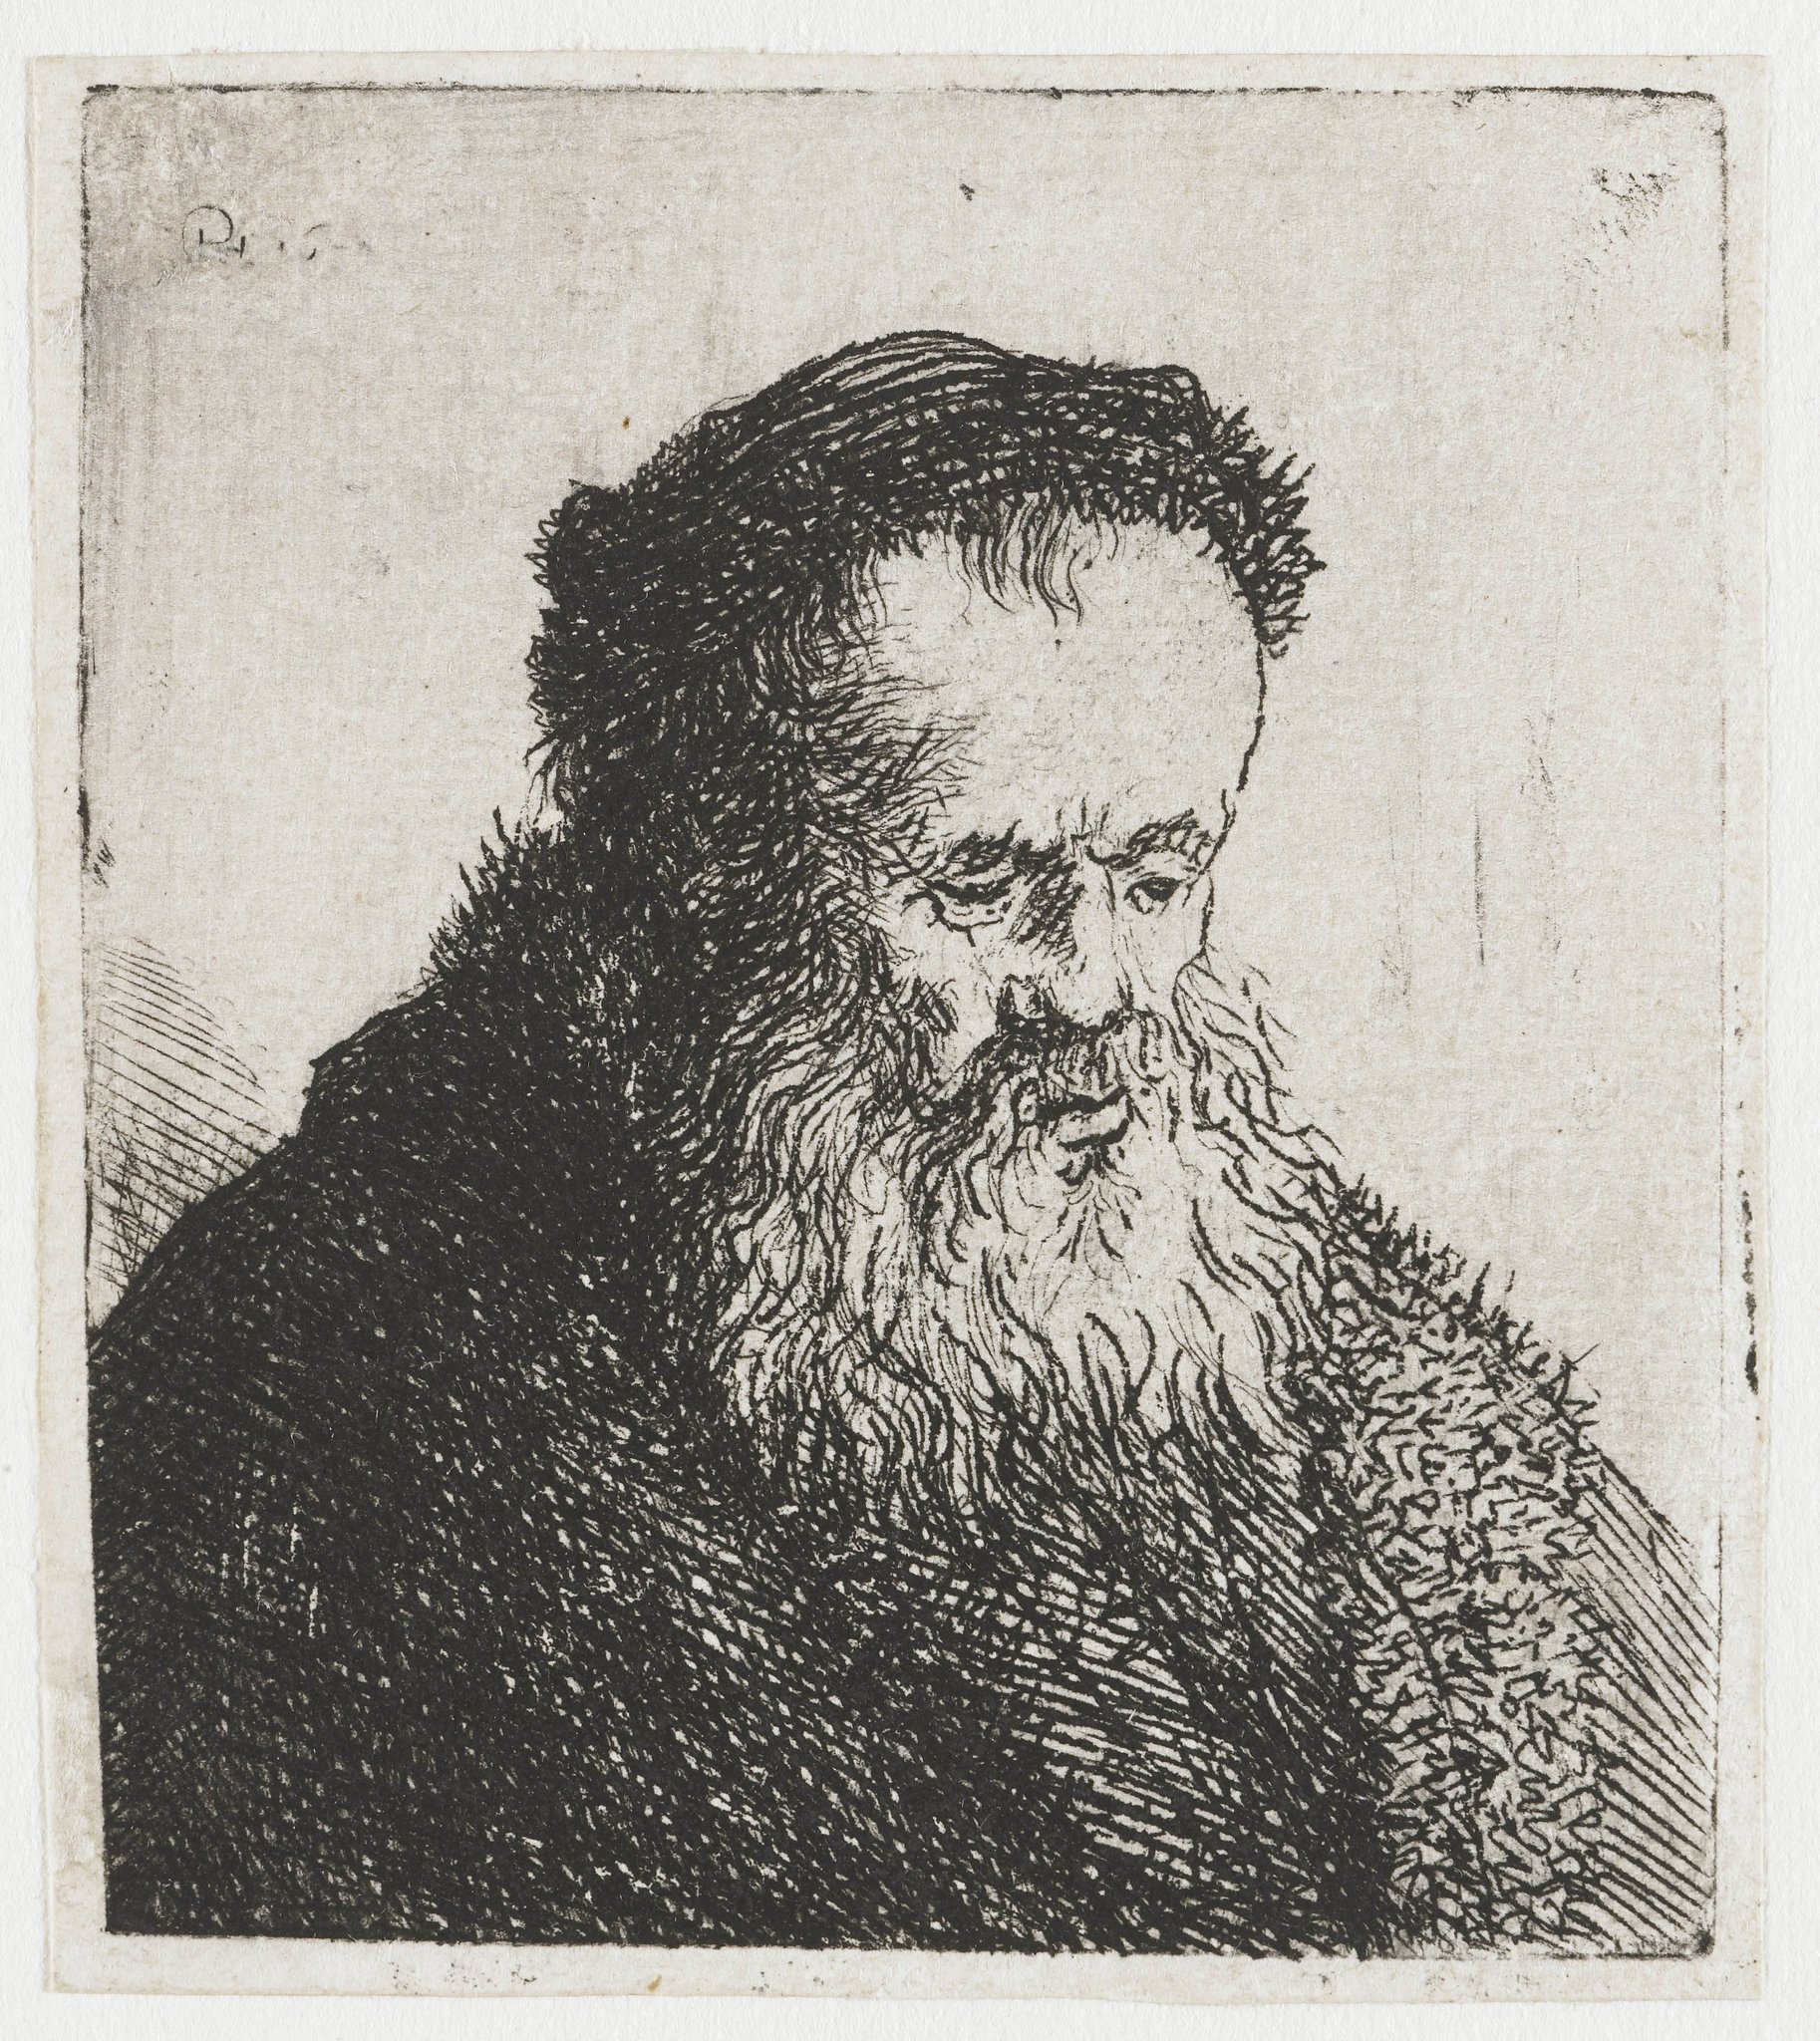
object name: print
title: Bearded old man with high forehead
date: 1629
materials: paper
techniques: etching, intaglio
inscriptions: collector's mark: Lugt 2165, monogram and date: ‘Rt 163’